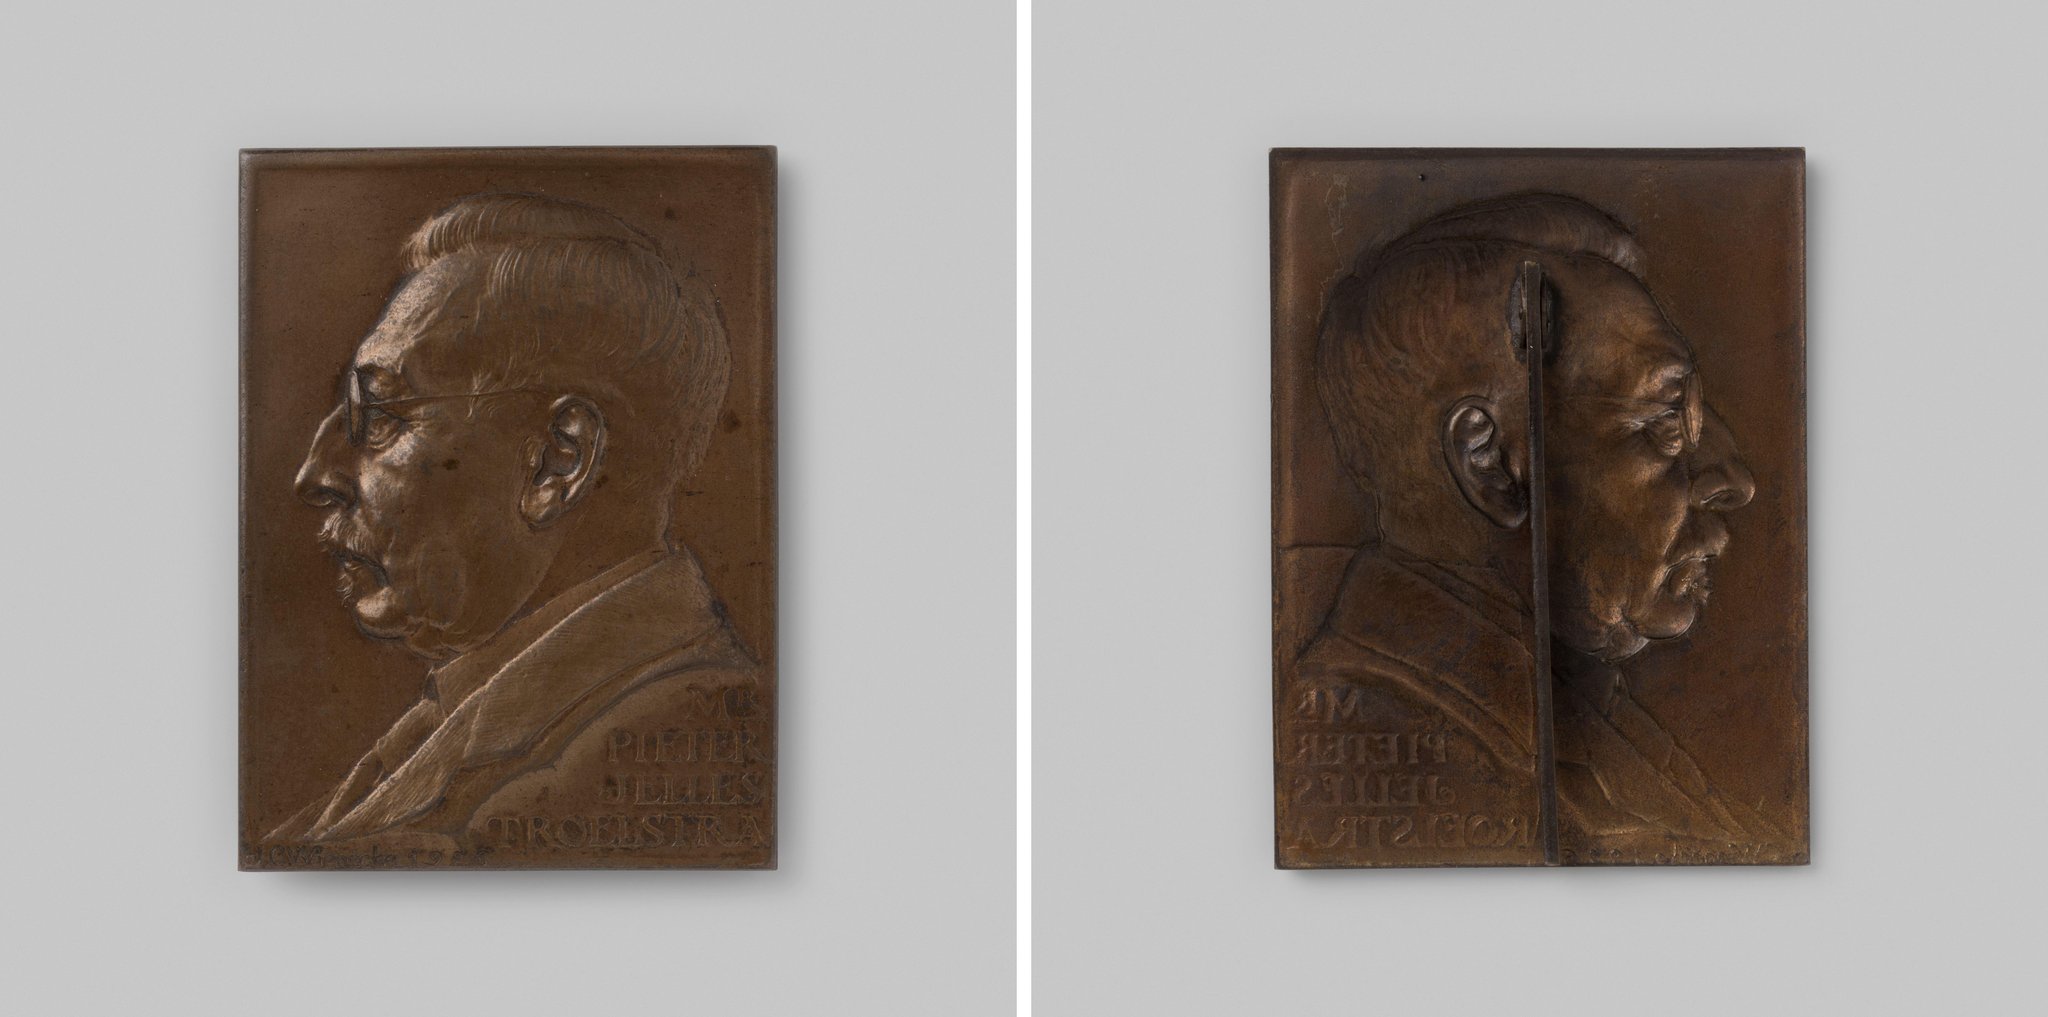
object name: plaque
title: Mr. Pieter Jelles Troelstra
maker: johannes cornelis wienecke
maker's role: medailleur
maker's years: 1872-1945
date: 1926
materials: bronze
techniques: striking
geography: apeldoorn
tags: politician, netherlands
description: Eenzijdige bronzen plaquette met aan de achterzijde een standaard. Voorzijde: portret van man (P.J. Troelstra) in profiel naar links.